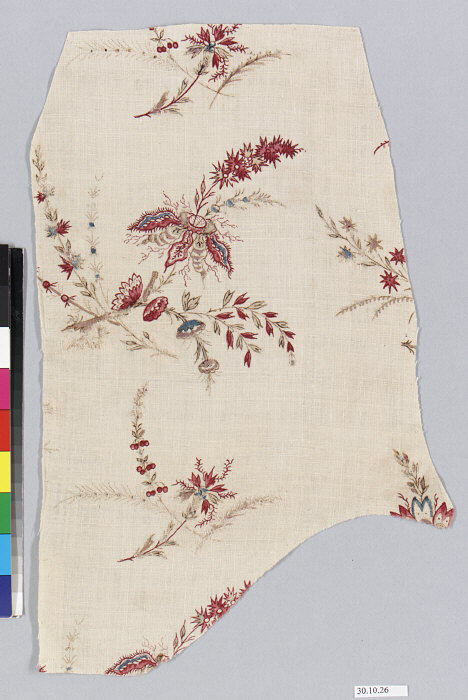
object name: piece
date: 1701-1800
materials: linen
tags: flowers,leaves